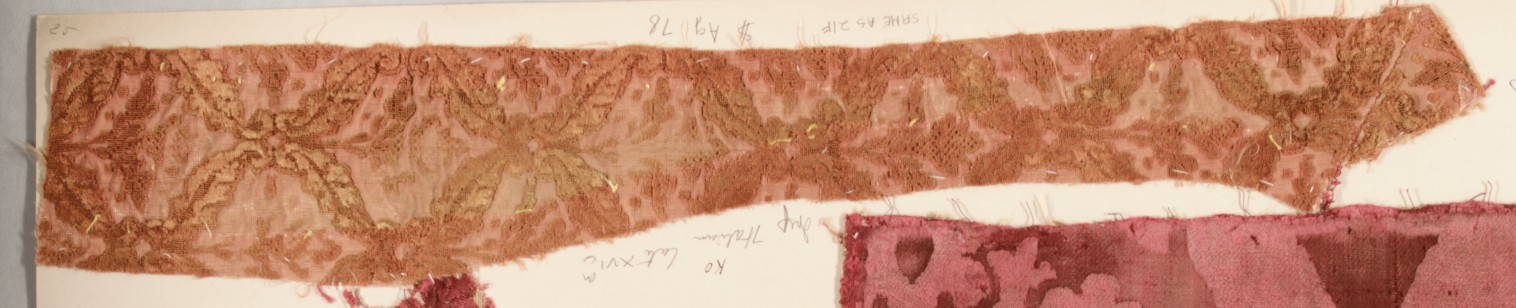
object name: fragment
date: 1567-1600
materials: silk